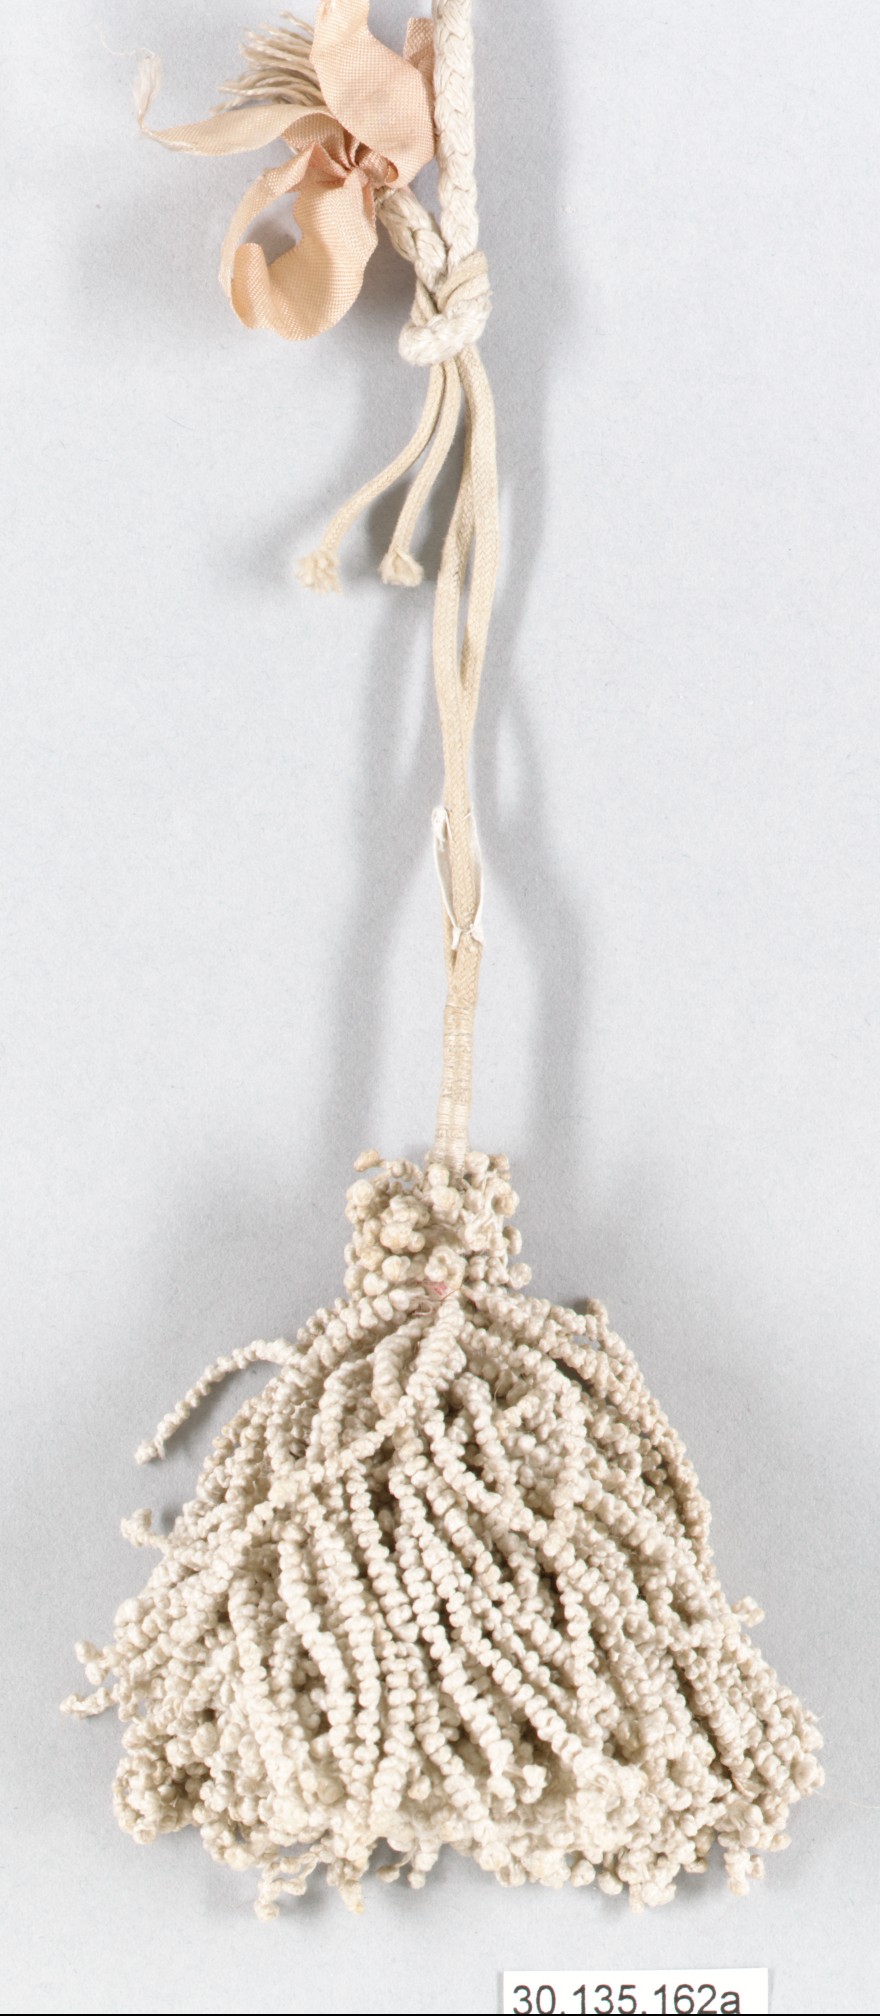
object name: tassel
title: Pair of tassels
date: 1601-1700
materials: linen